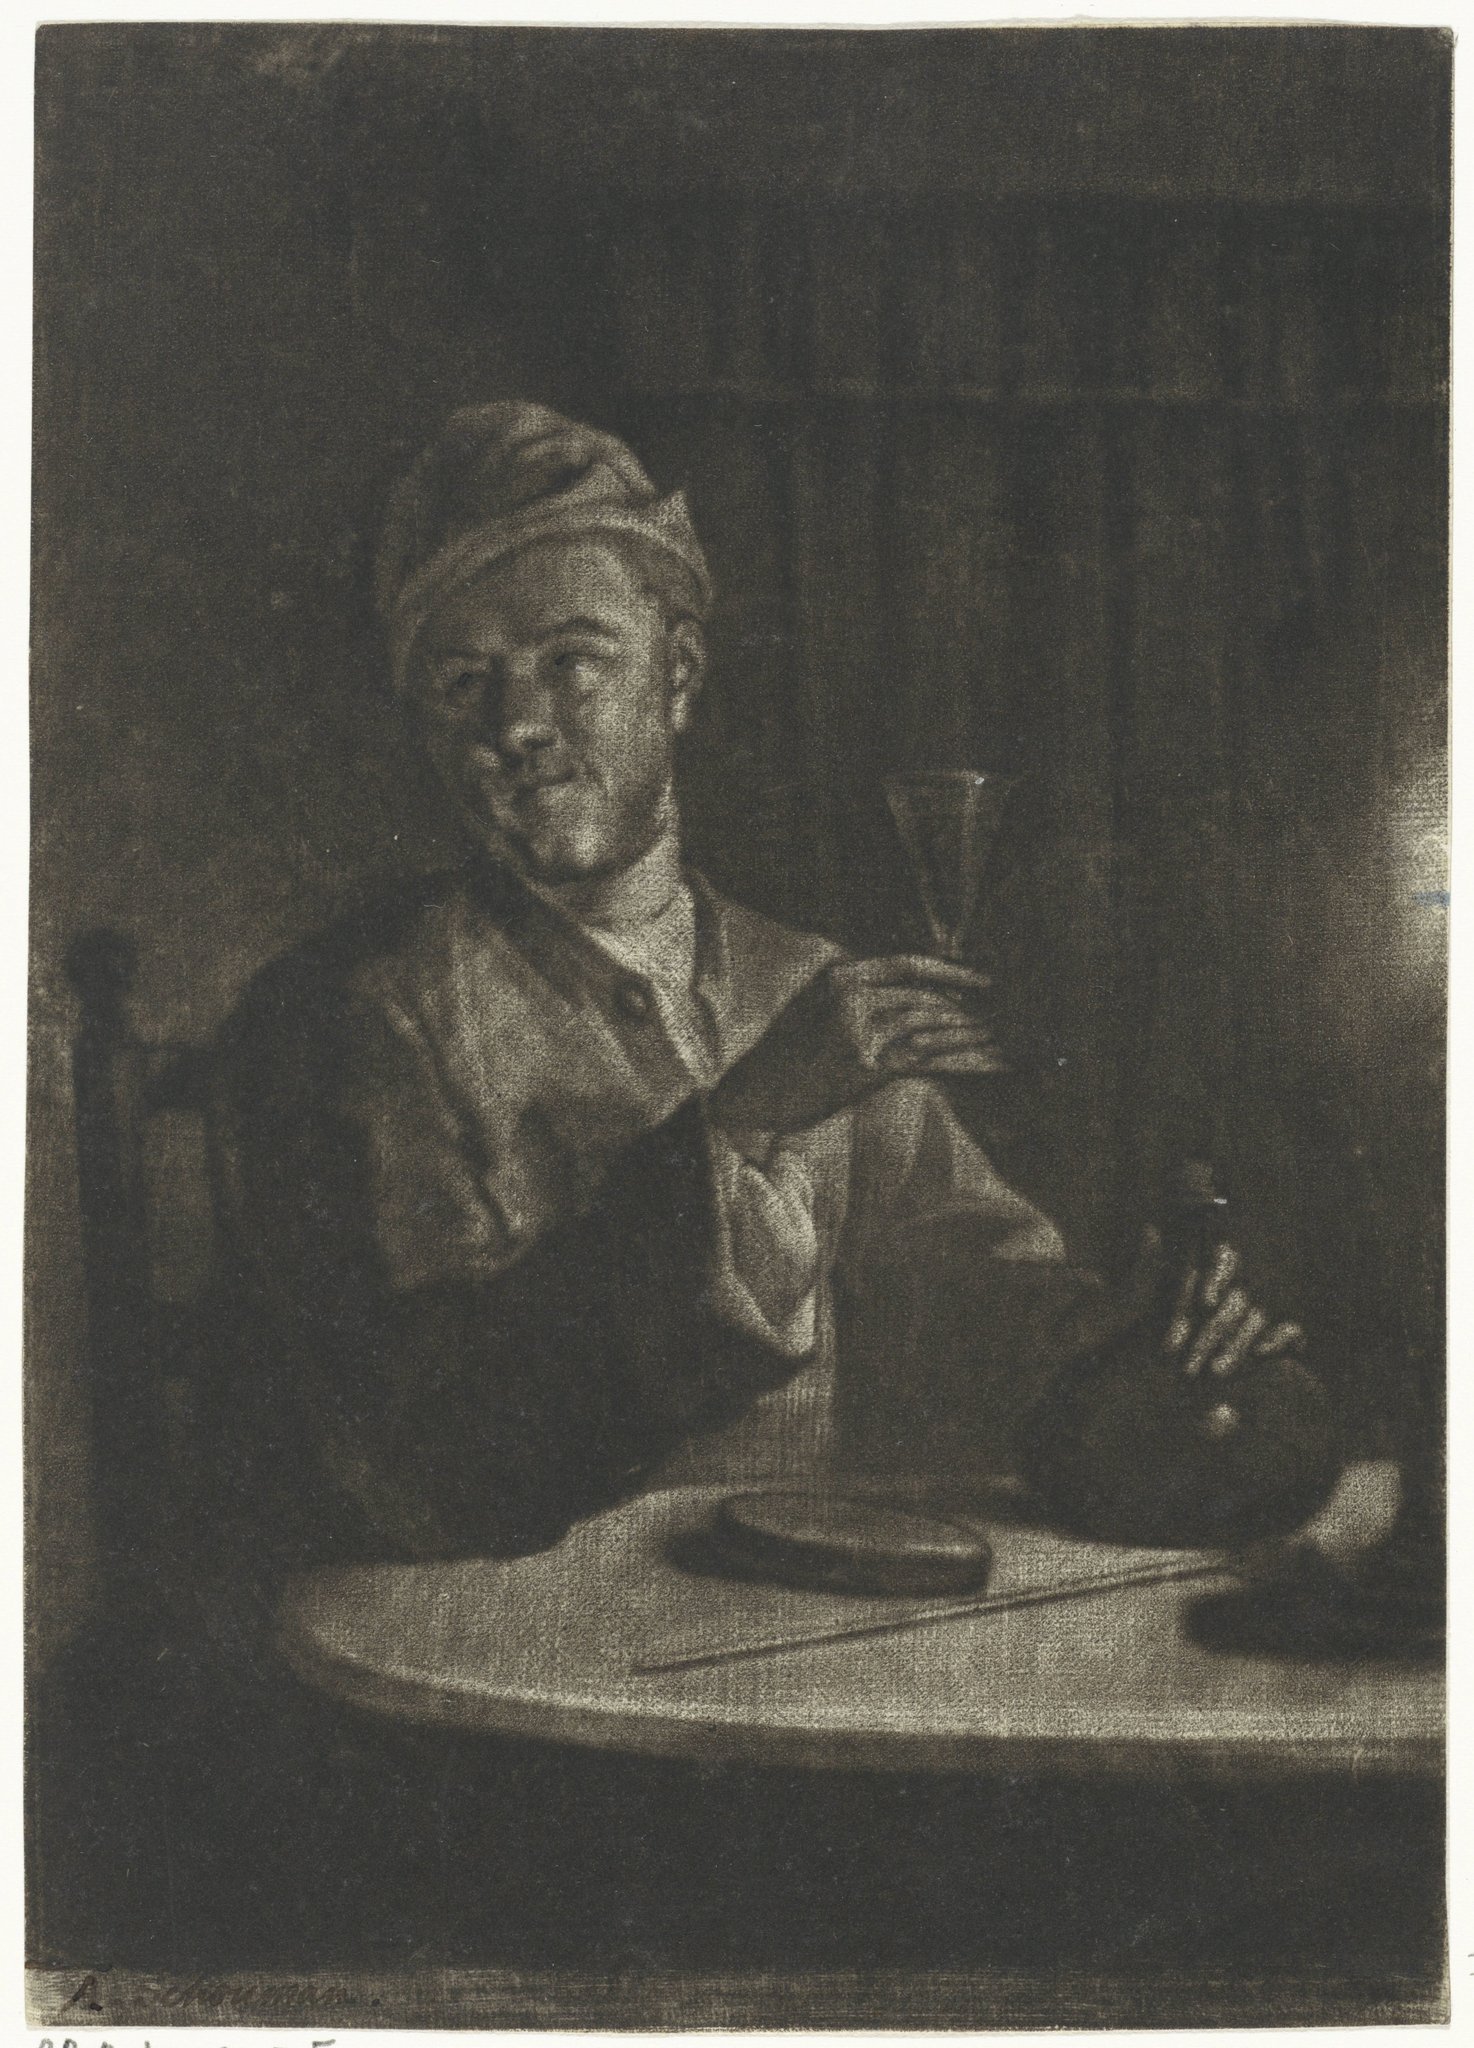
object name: print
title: Man met opgeheven glas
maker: aert schouman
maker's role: draughtsman, painter, print maker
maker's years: 1710-1792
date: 1720-1792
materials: paper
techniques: mezzotint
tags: pipe ~ tobacco, candle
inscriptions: collector's mark: Lugt 2228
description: Een man heft zijn glas, bij kaarslicht. Hij zit aan een tafel waarop een drankkruik en een pijp liggen.